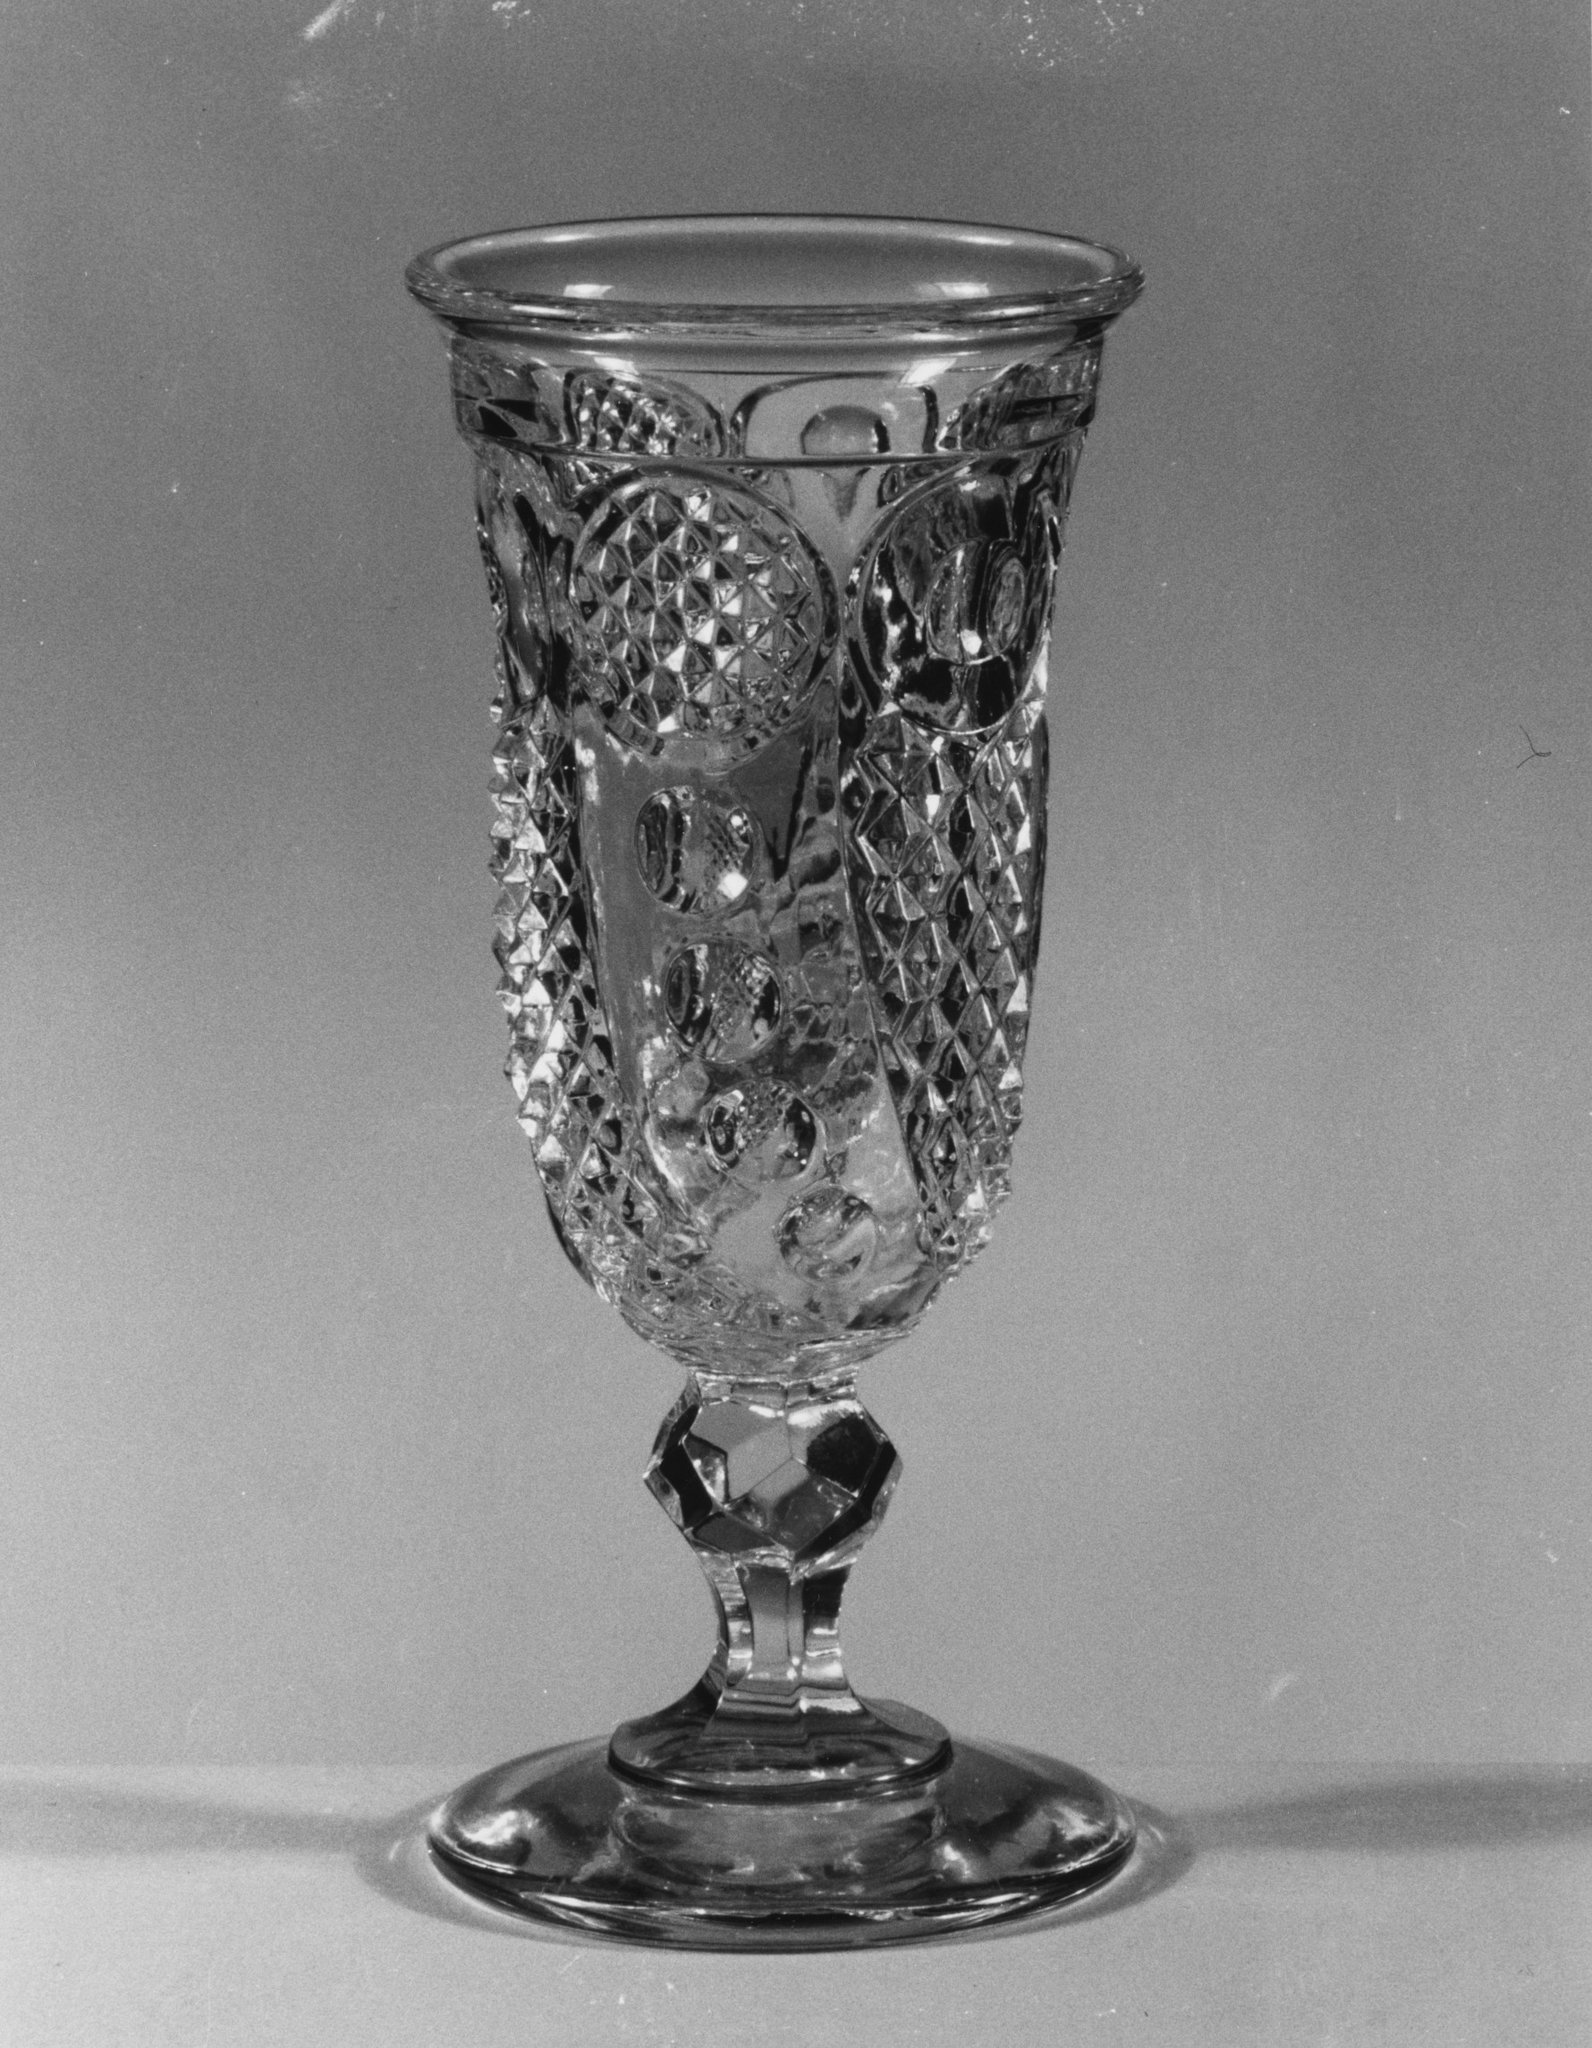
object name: claret glass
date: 1850-1870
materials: glass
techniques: pressed